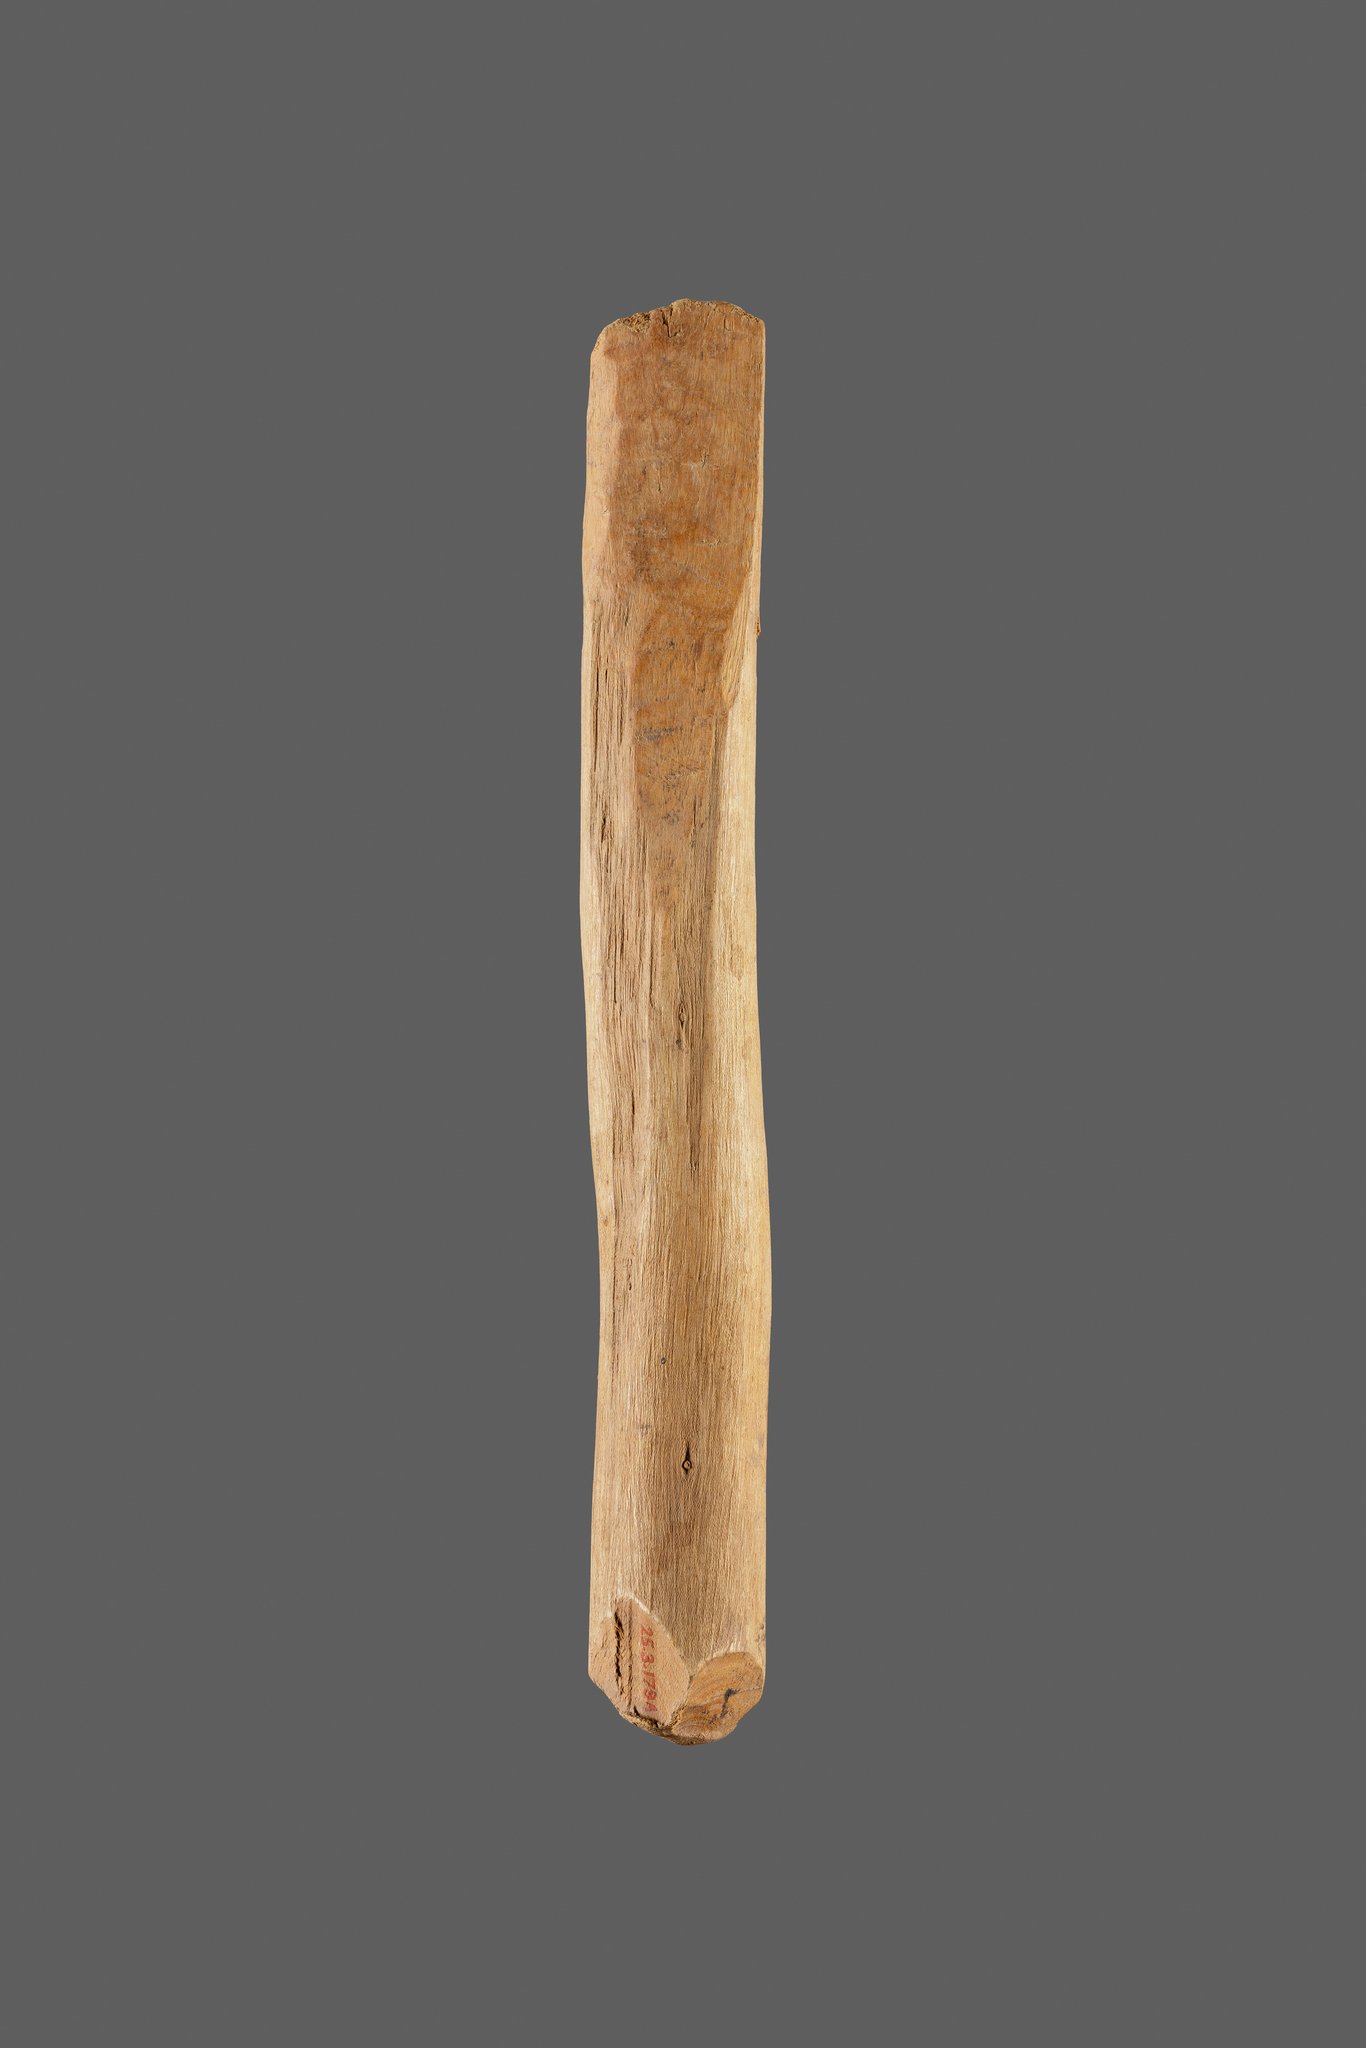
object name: wedge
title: Plunderers' Wedge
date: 1070-945 BCE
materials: wood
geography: egypt